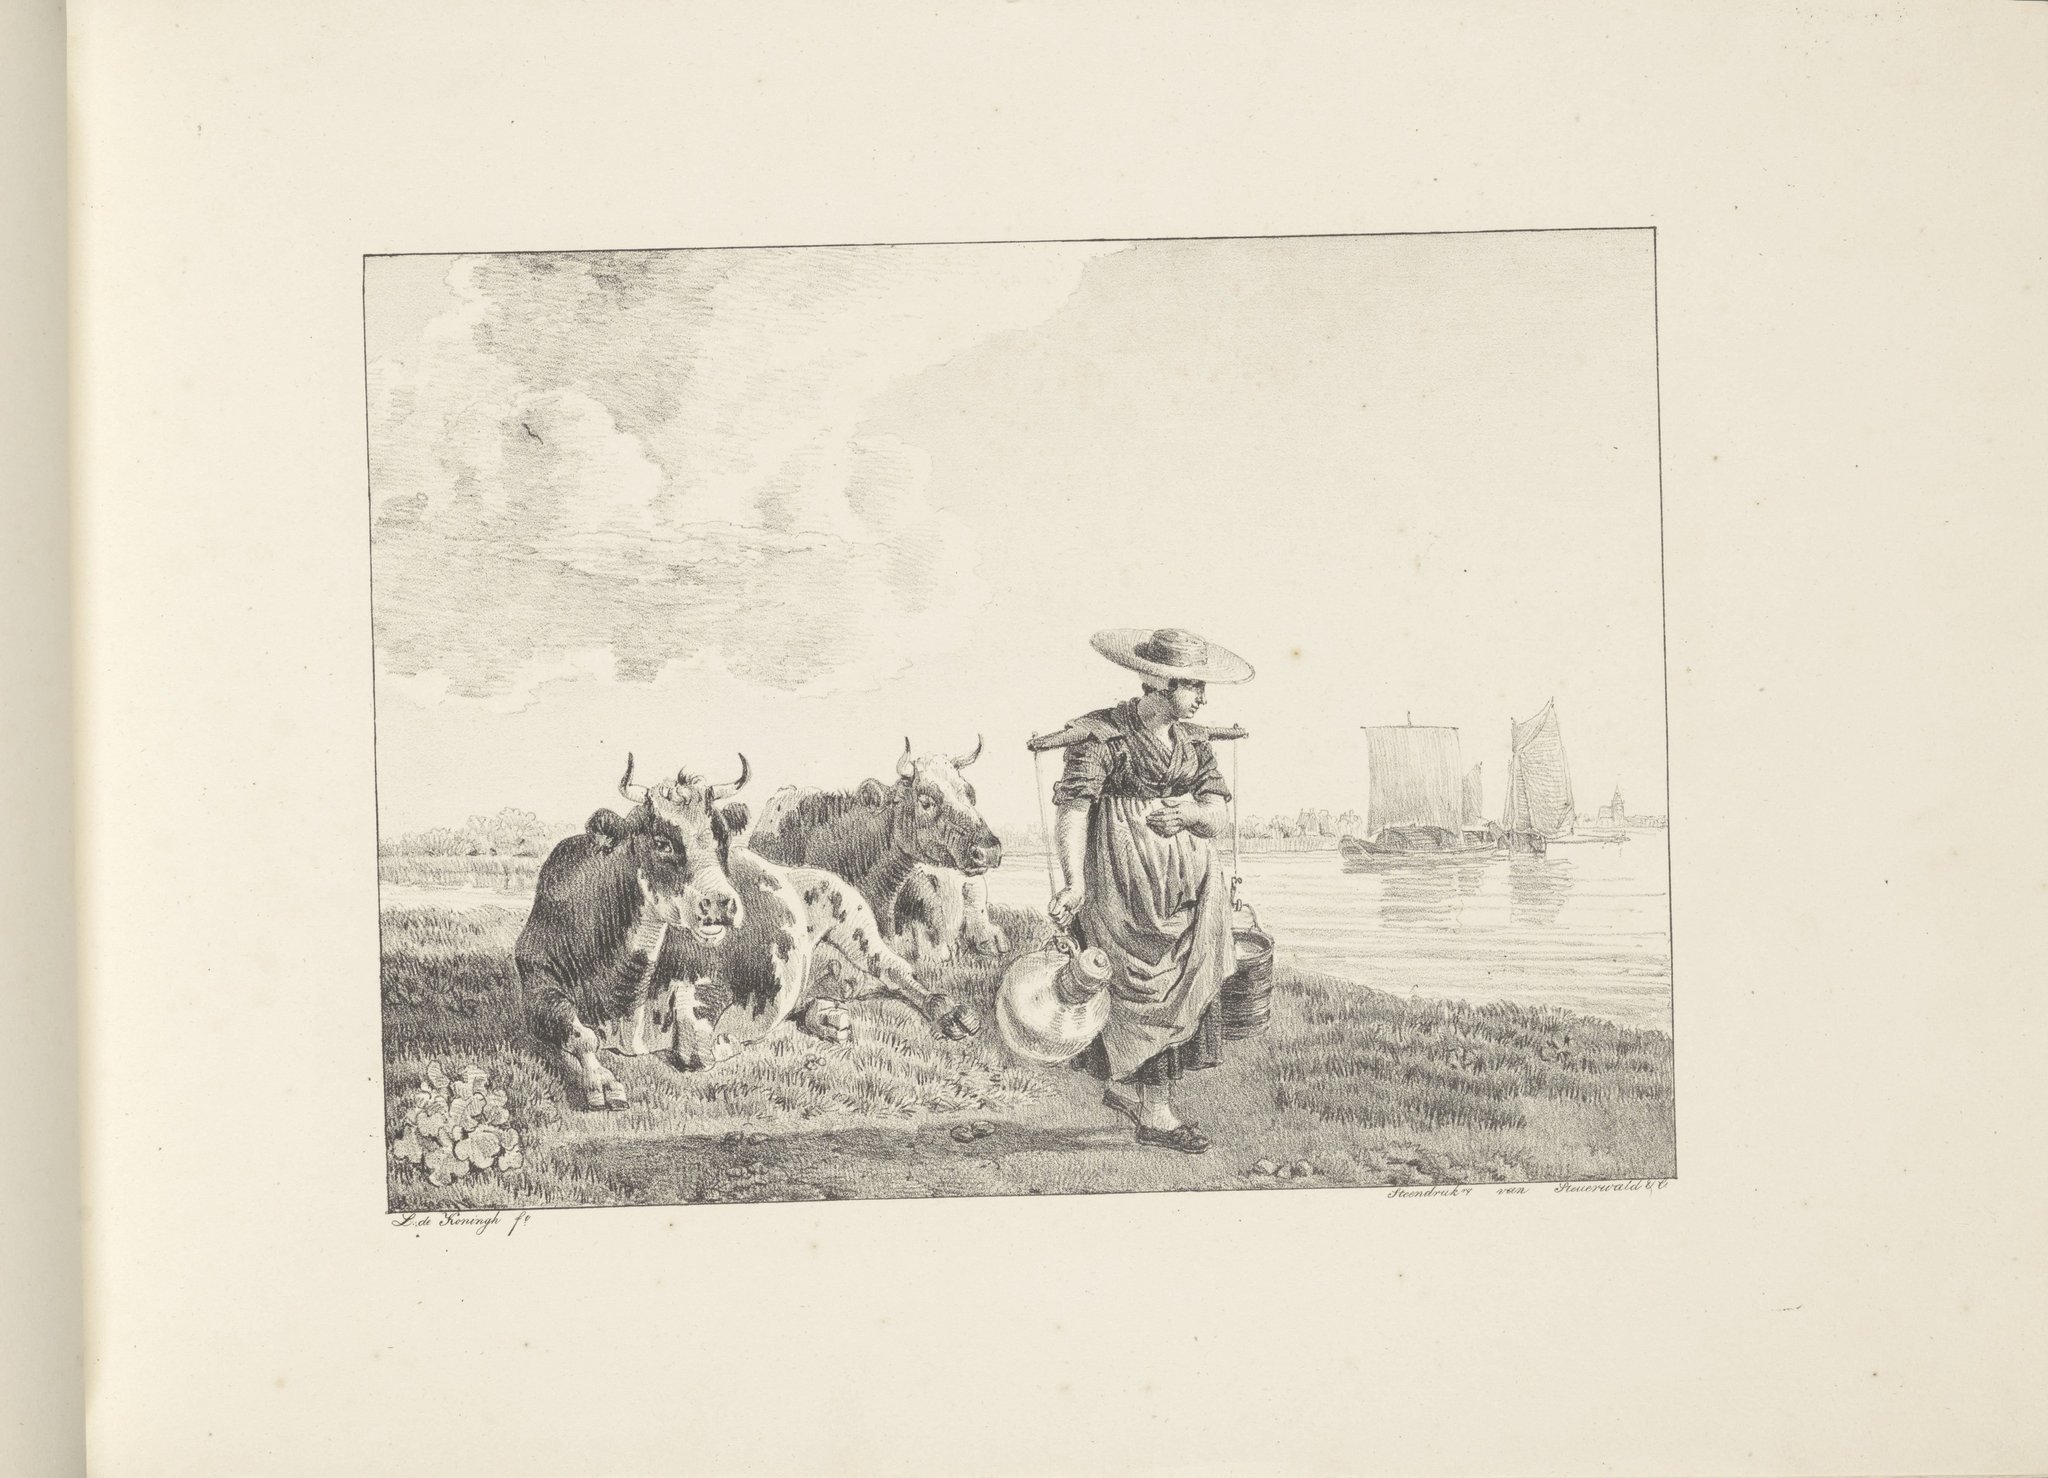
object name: print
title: Teekeningen naar Beesten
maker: leendert de koningh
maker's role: draughtsman, print maker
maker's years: 1777-1849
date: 1826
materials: paper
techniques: lithograph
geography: dordrecht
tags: cow, carrying something with yoke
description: De boerin draagt een juk met daaraan een emmer en een vat melk. Deze prent behoort tot een serie van zes prenten, samengebonden met een titelblad.